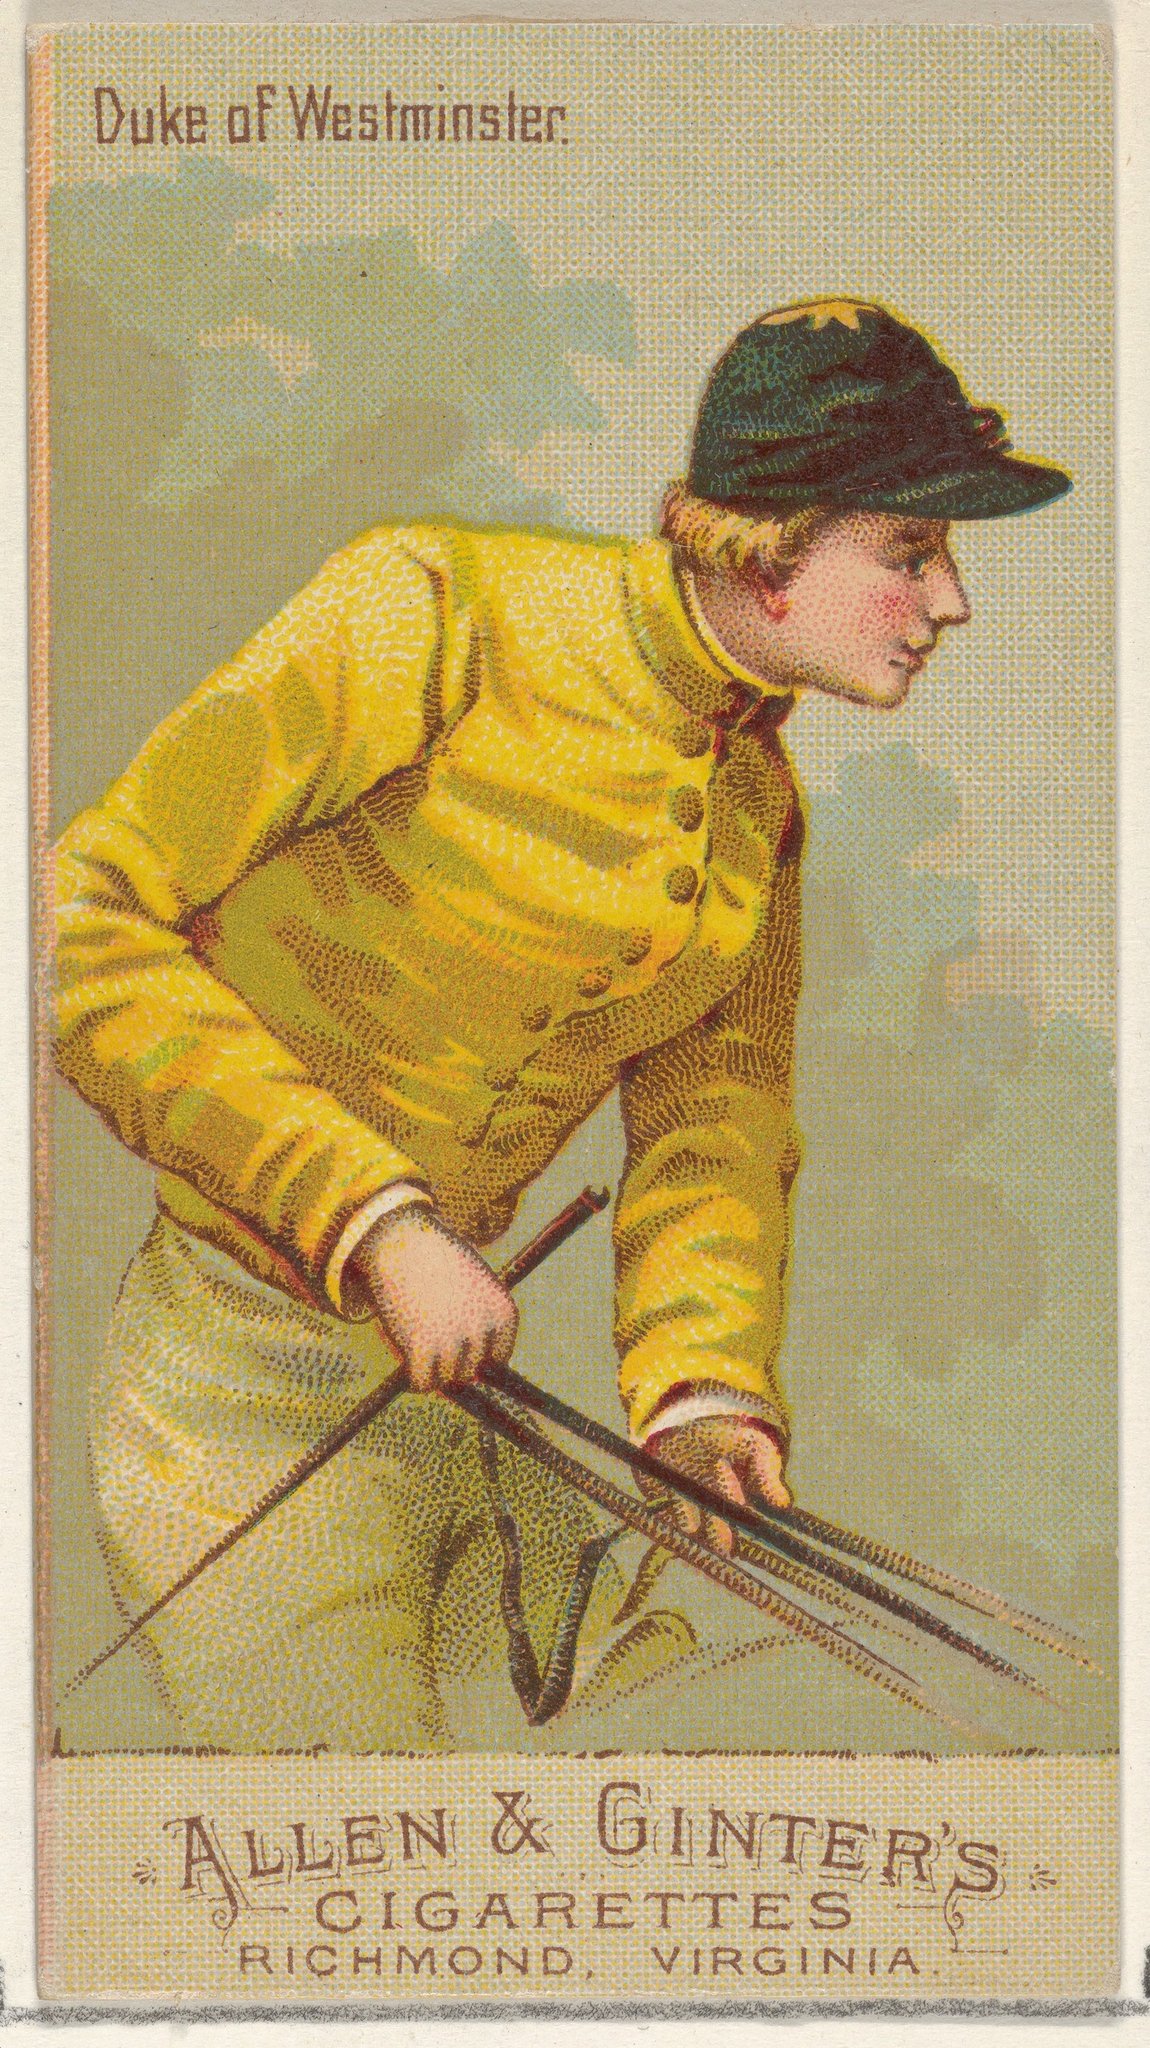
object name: print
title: Duke of Westminster, from the Racing Colors of the World series (N22b) for Allen & Ginter Cigarettes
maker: allen & ginter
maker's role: publisher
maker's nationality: american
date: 1888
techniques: color lithograph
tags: men,profiles,jockeys